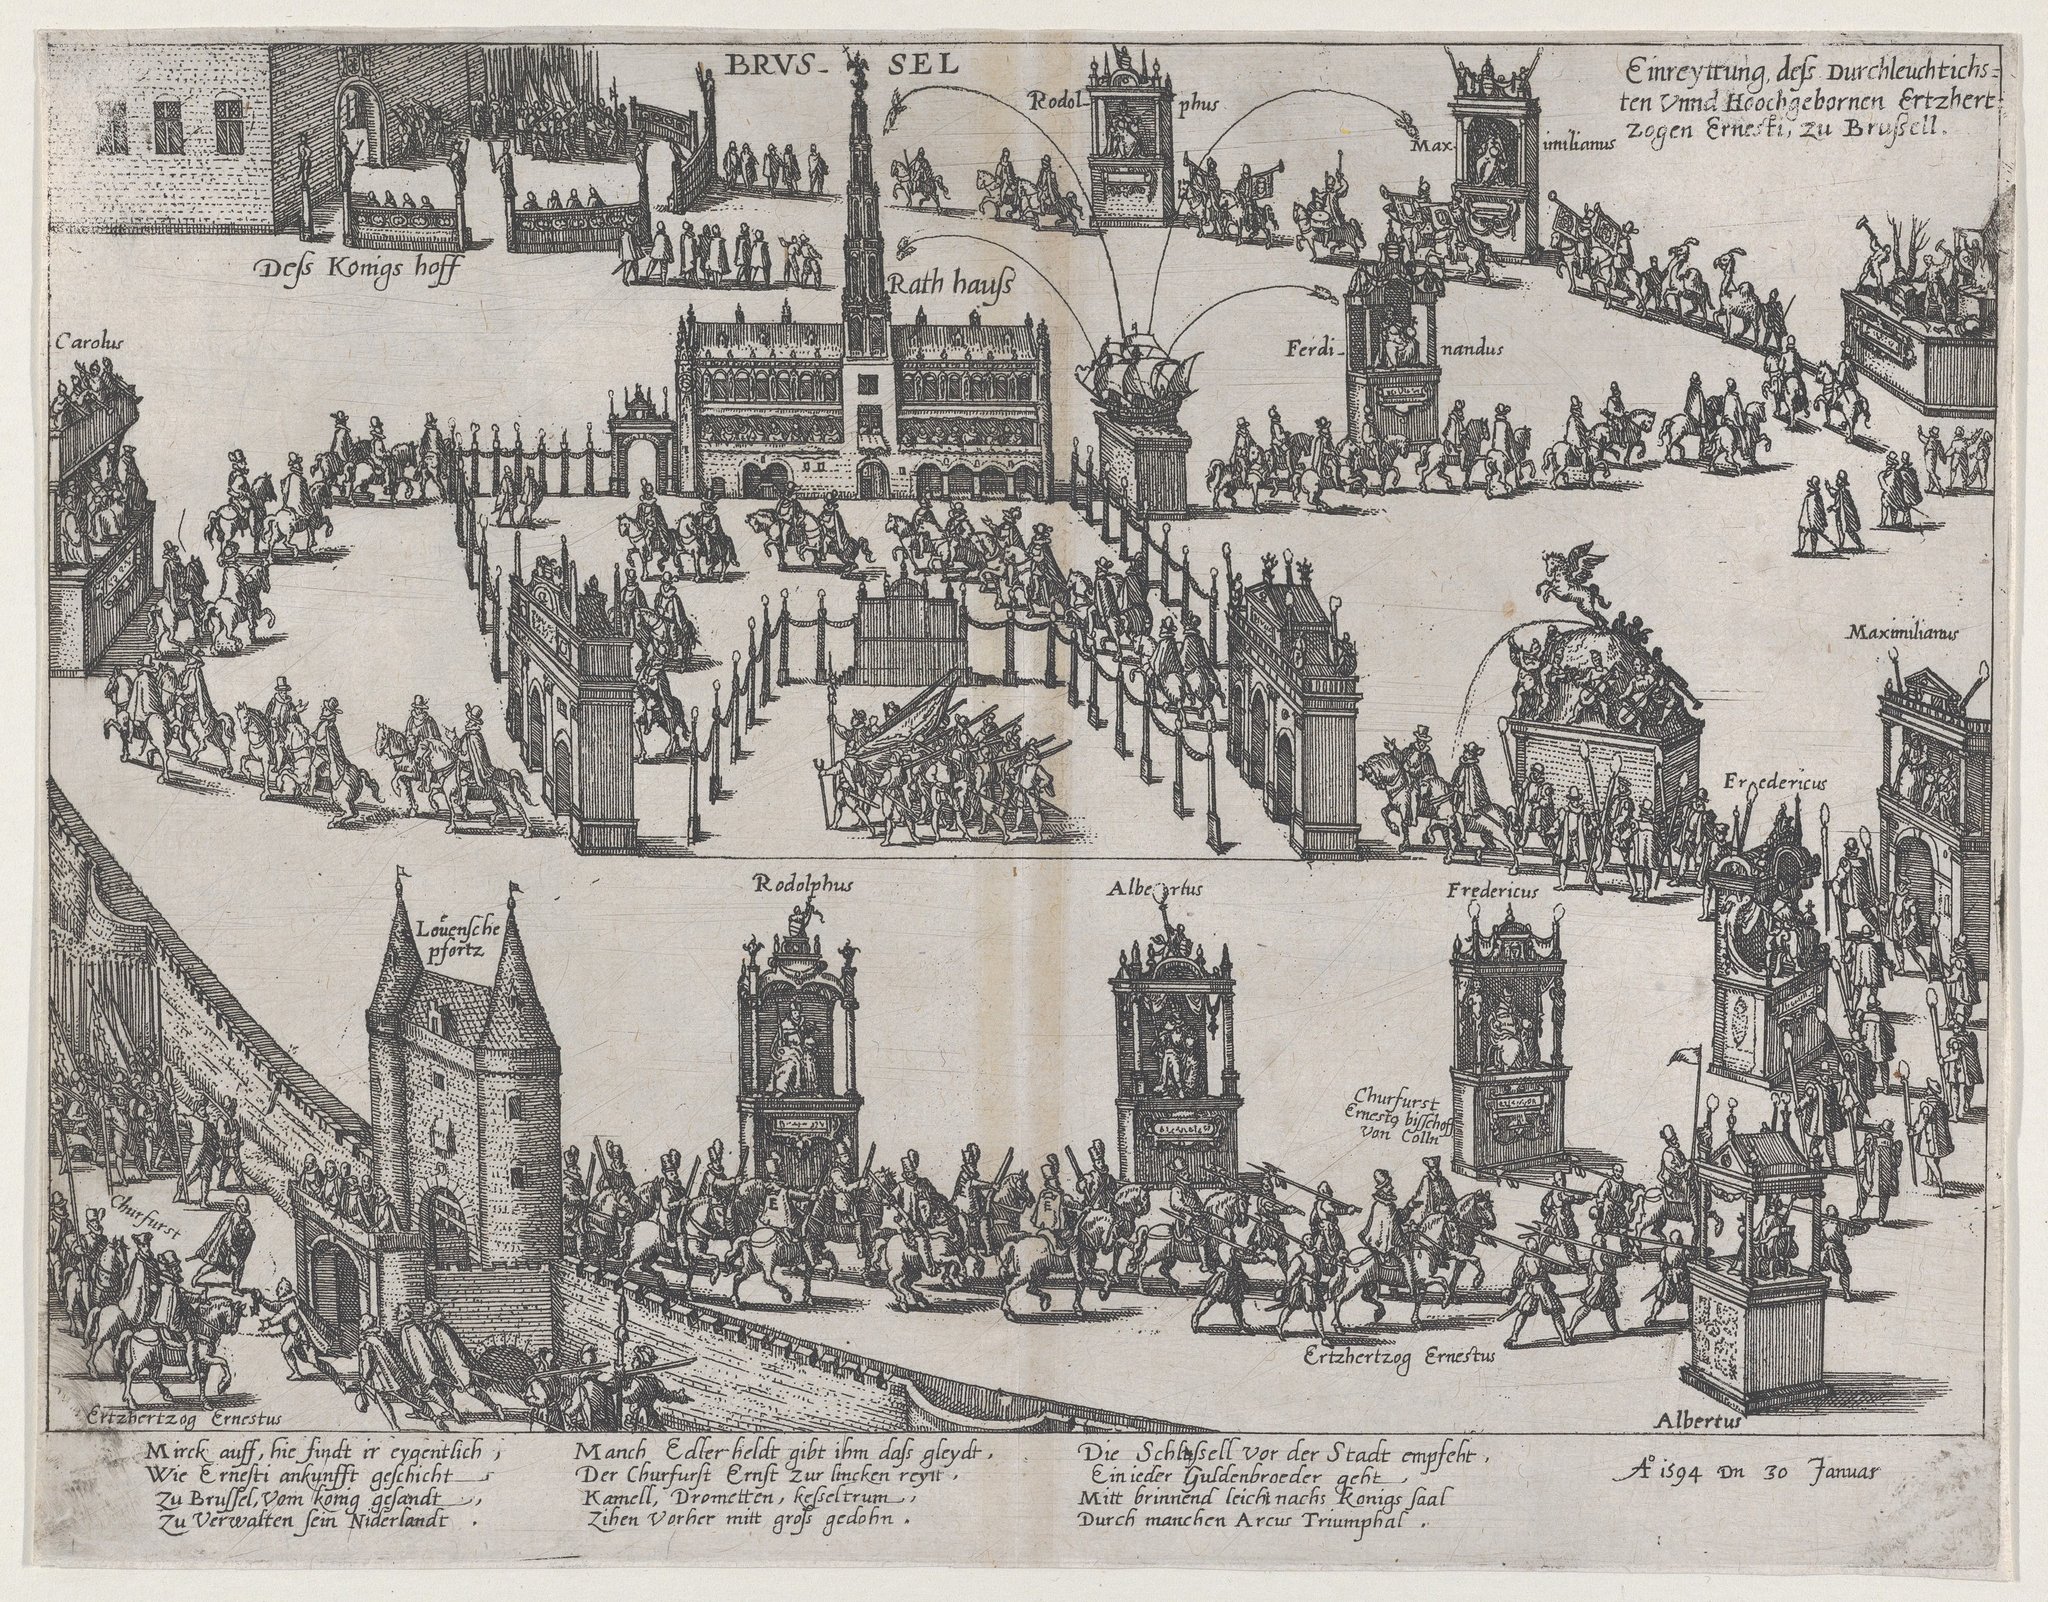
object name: print, fete, ornament architecture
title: Entrance of the Archduke Ernest to Brussels, January 30, 1594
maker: anonymous, german, 16th century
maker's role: artist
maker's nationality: german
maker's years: 1500-1600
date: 1594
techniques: etching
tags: buildings,doorways,soldiers,horses